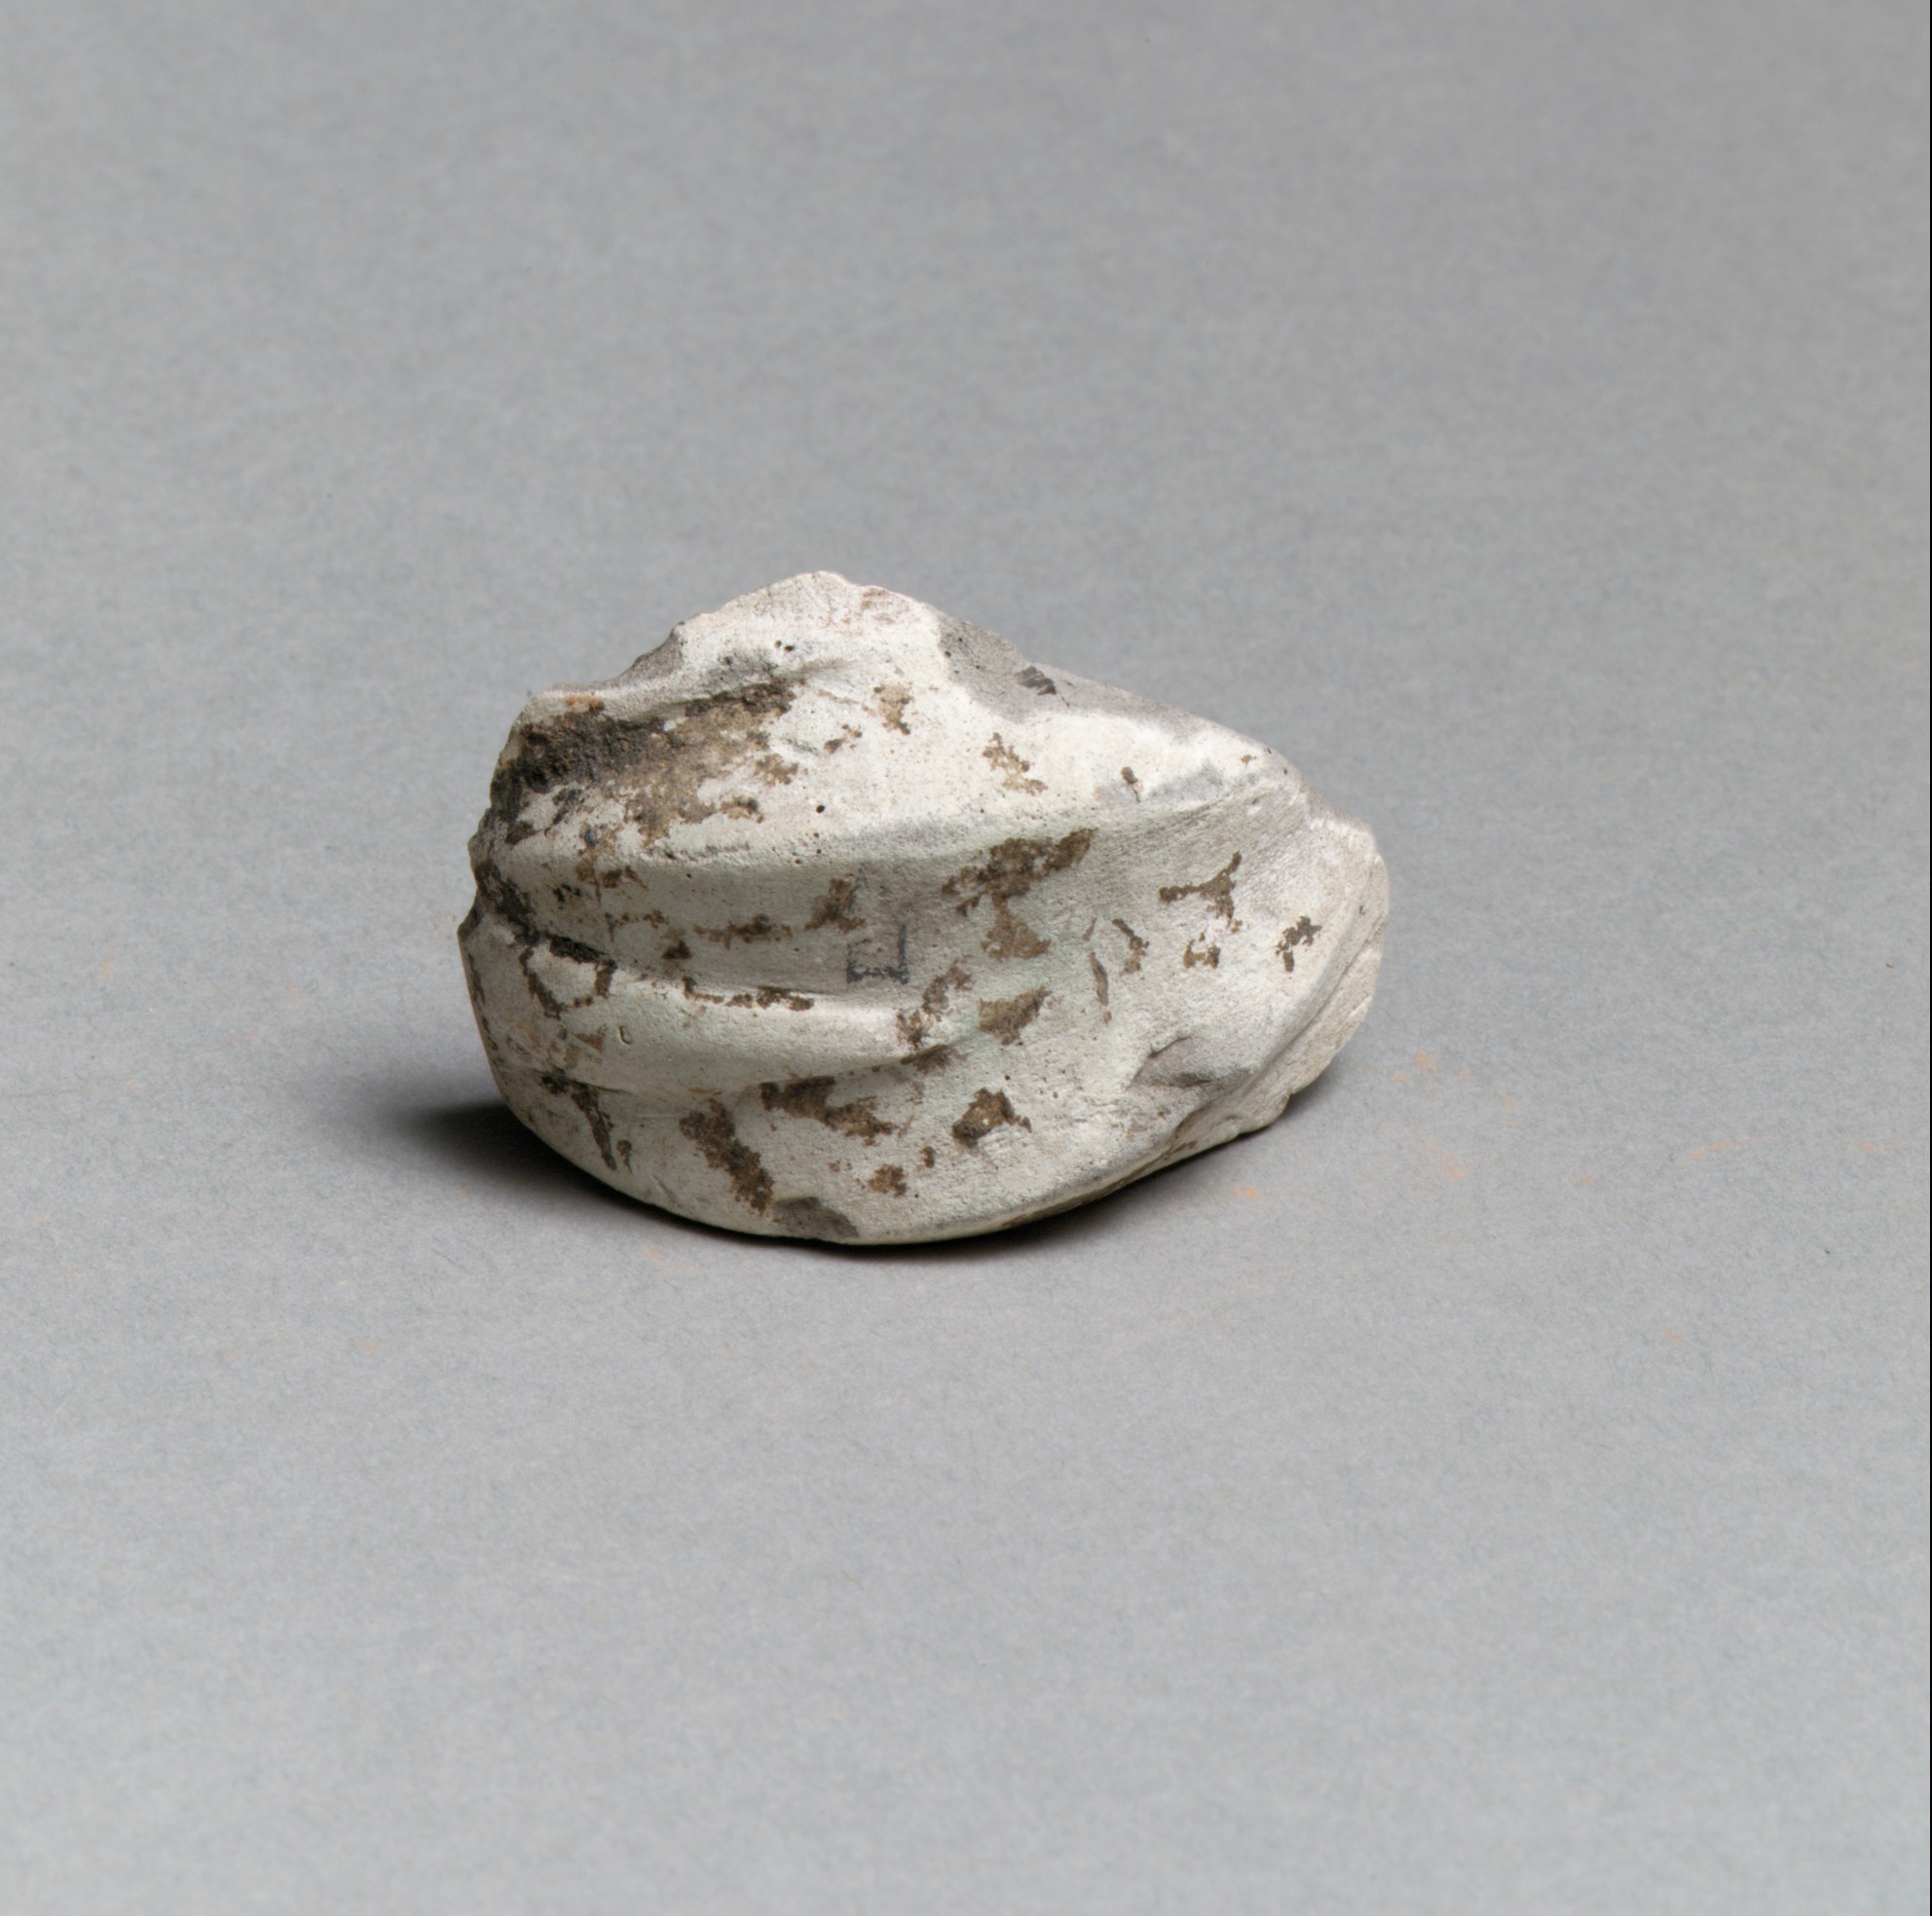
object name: vase fragment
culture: greek or lydian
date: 1050-700 BCE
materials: terracotta